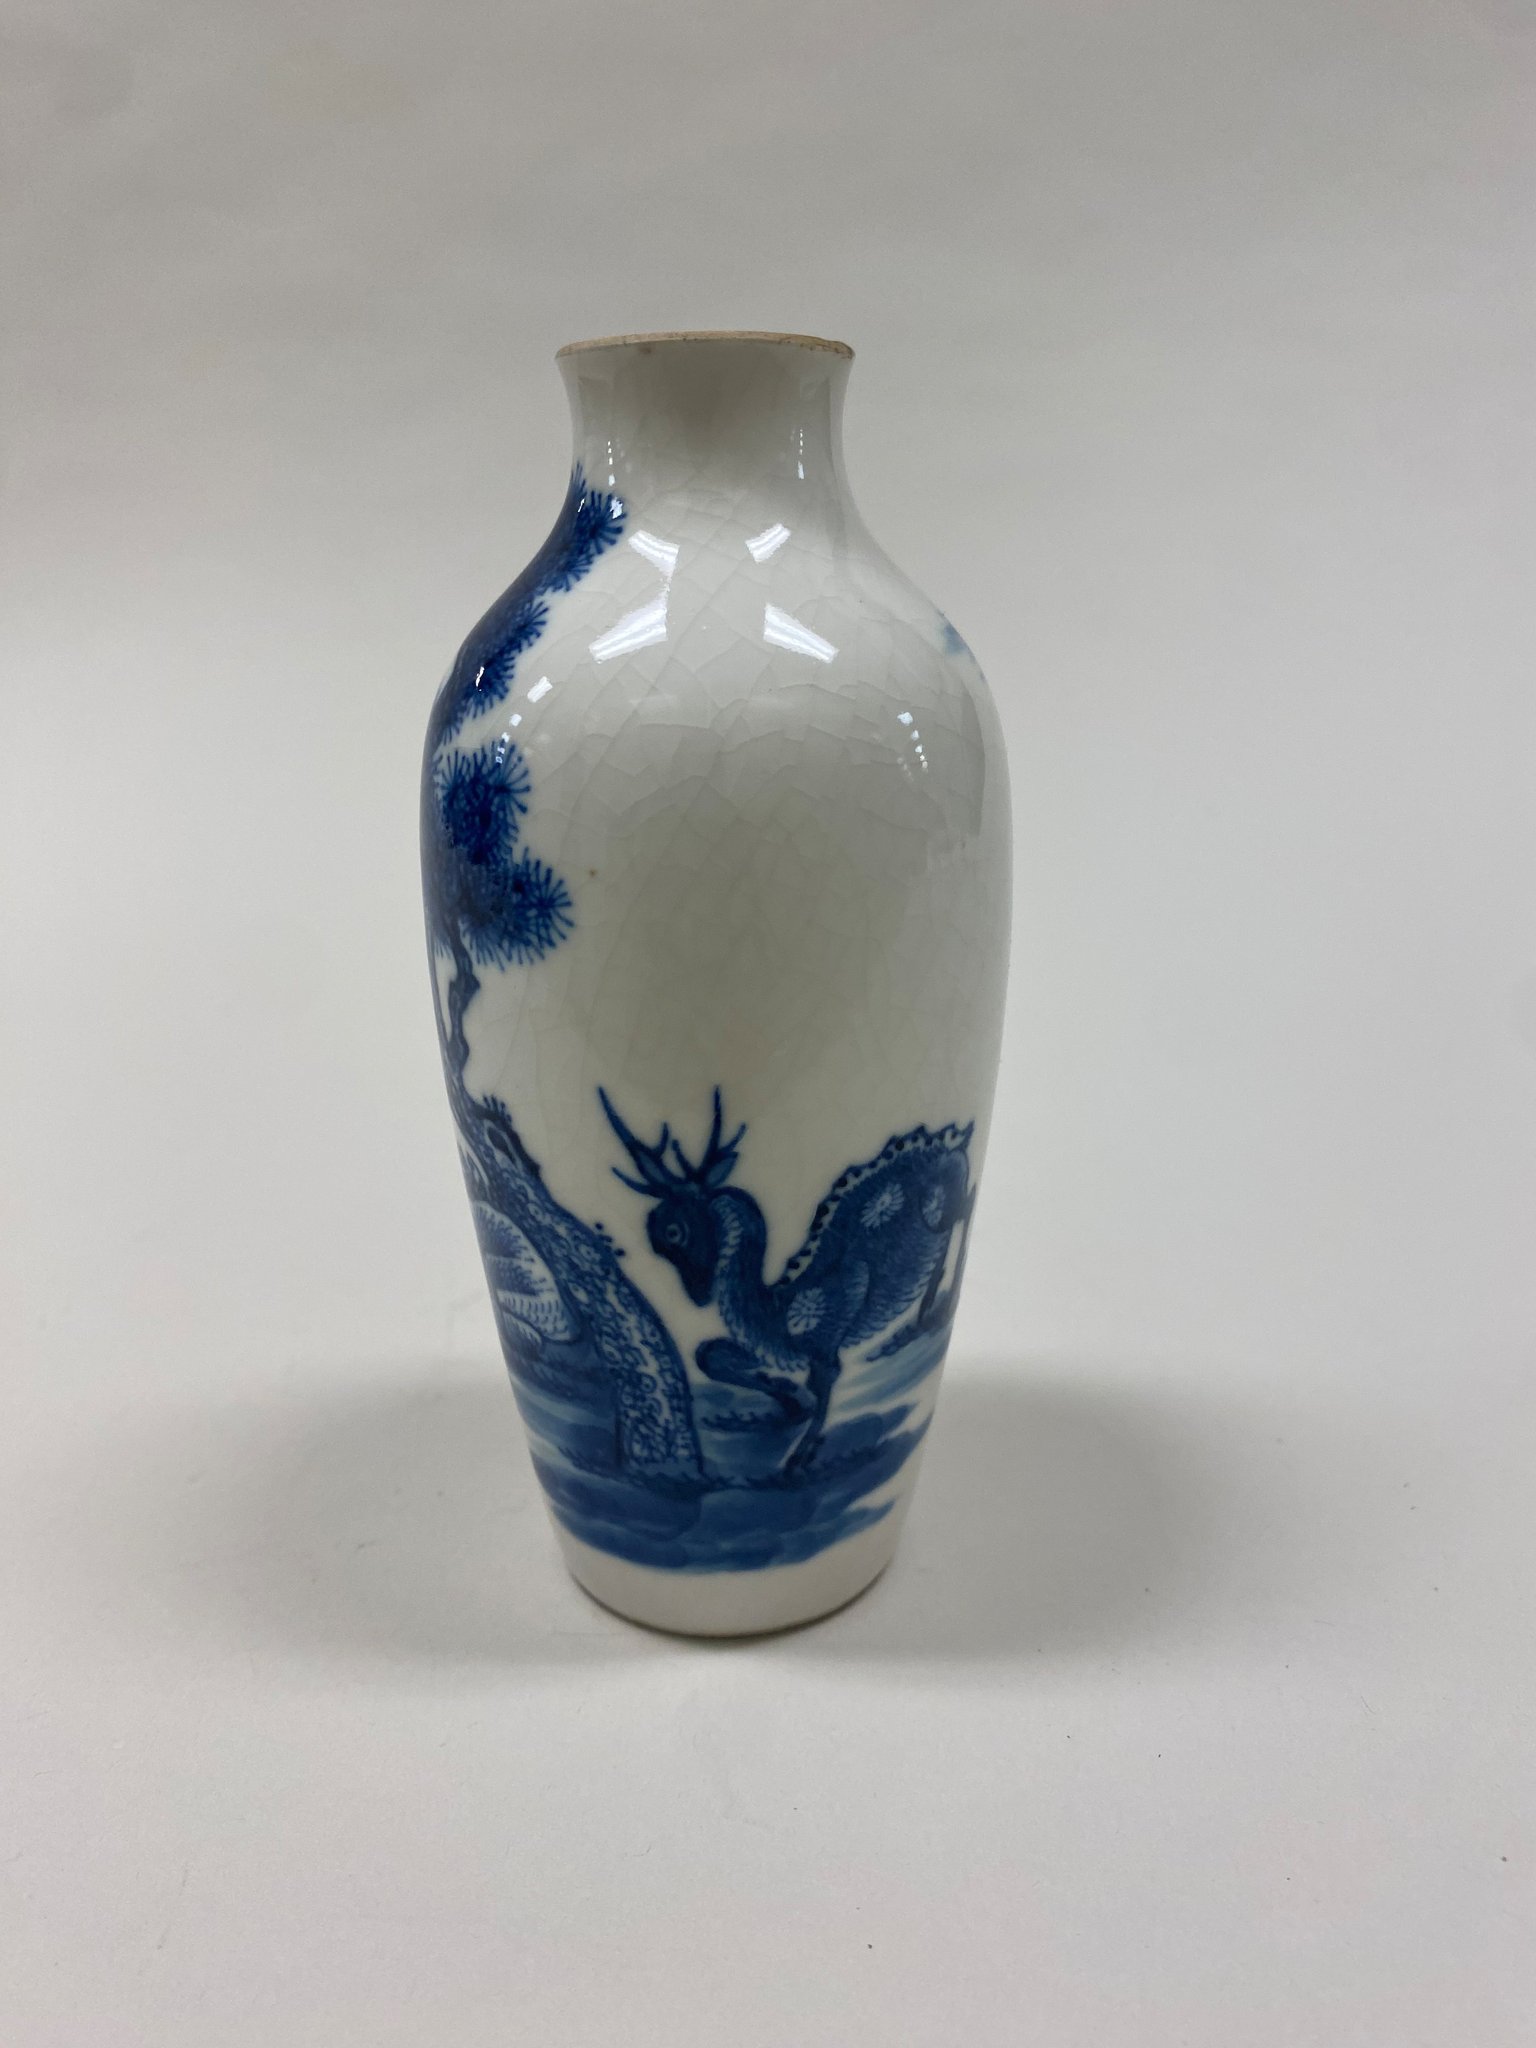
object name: vase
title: Vase with deer and pine tree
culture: chinese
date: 1701-1800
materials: cobalt, porcelain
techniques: painting, underglaze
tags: deer,trees